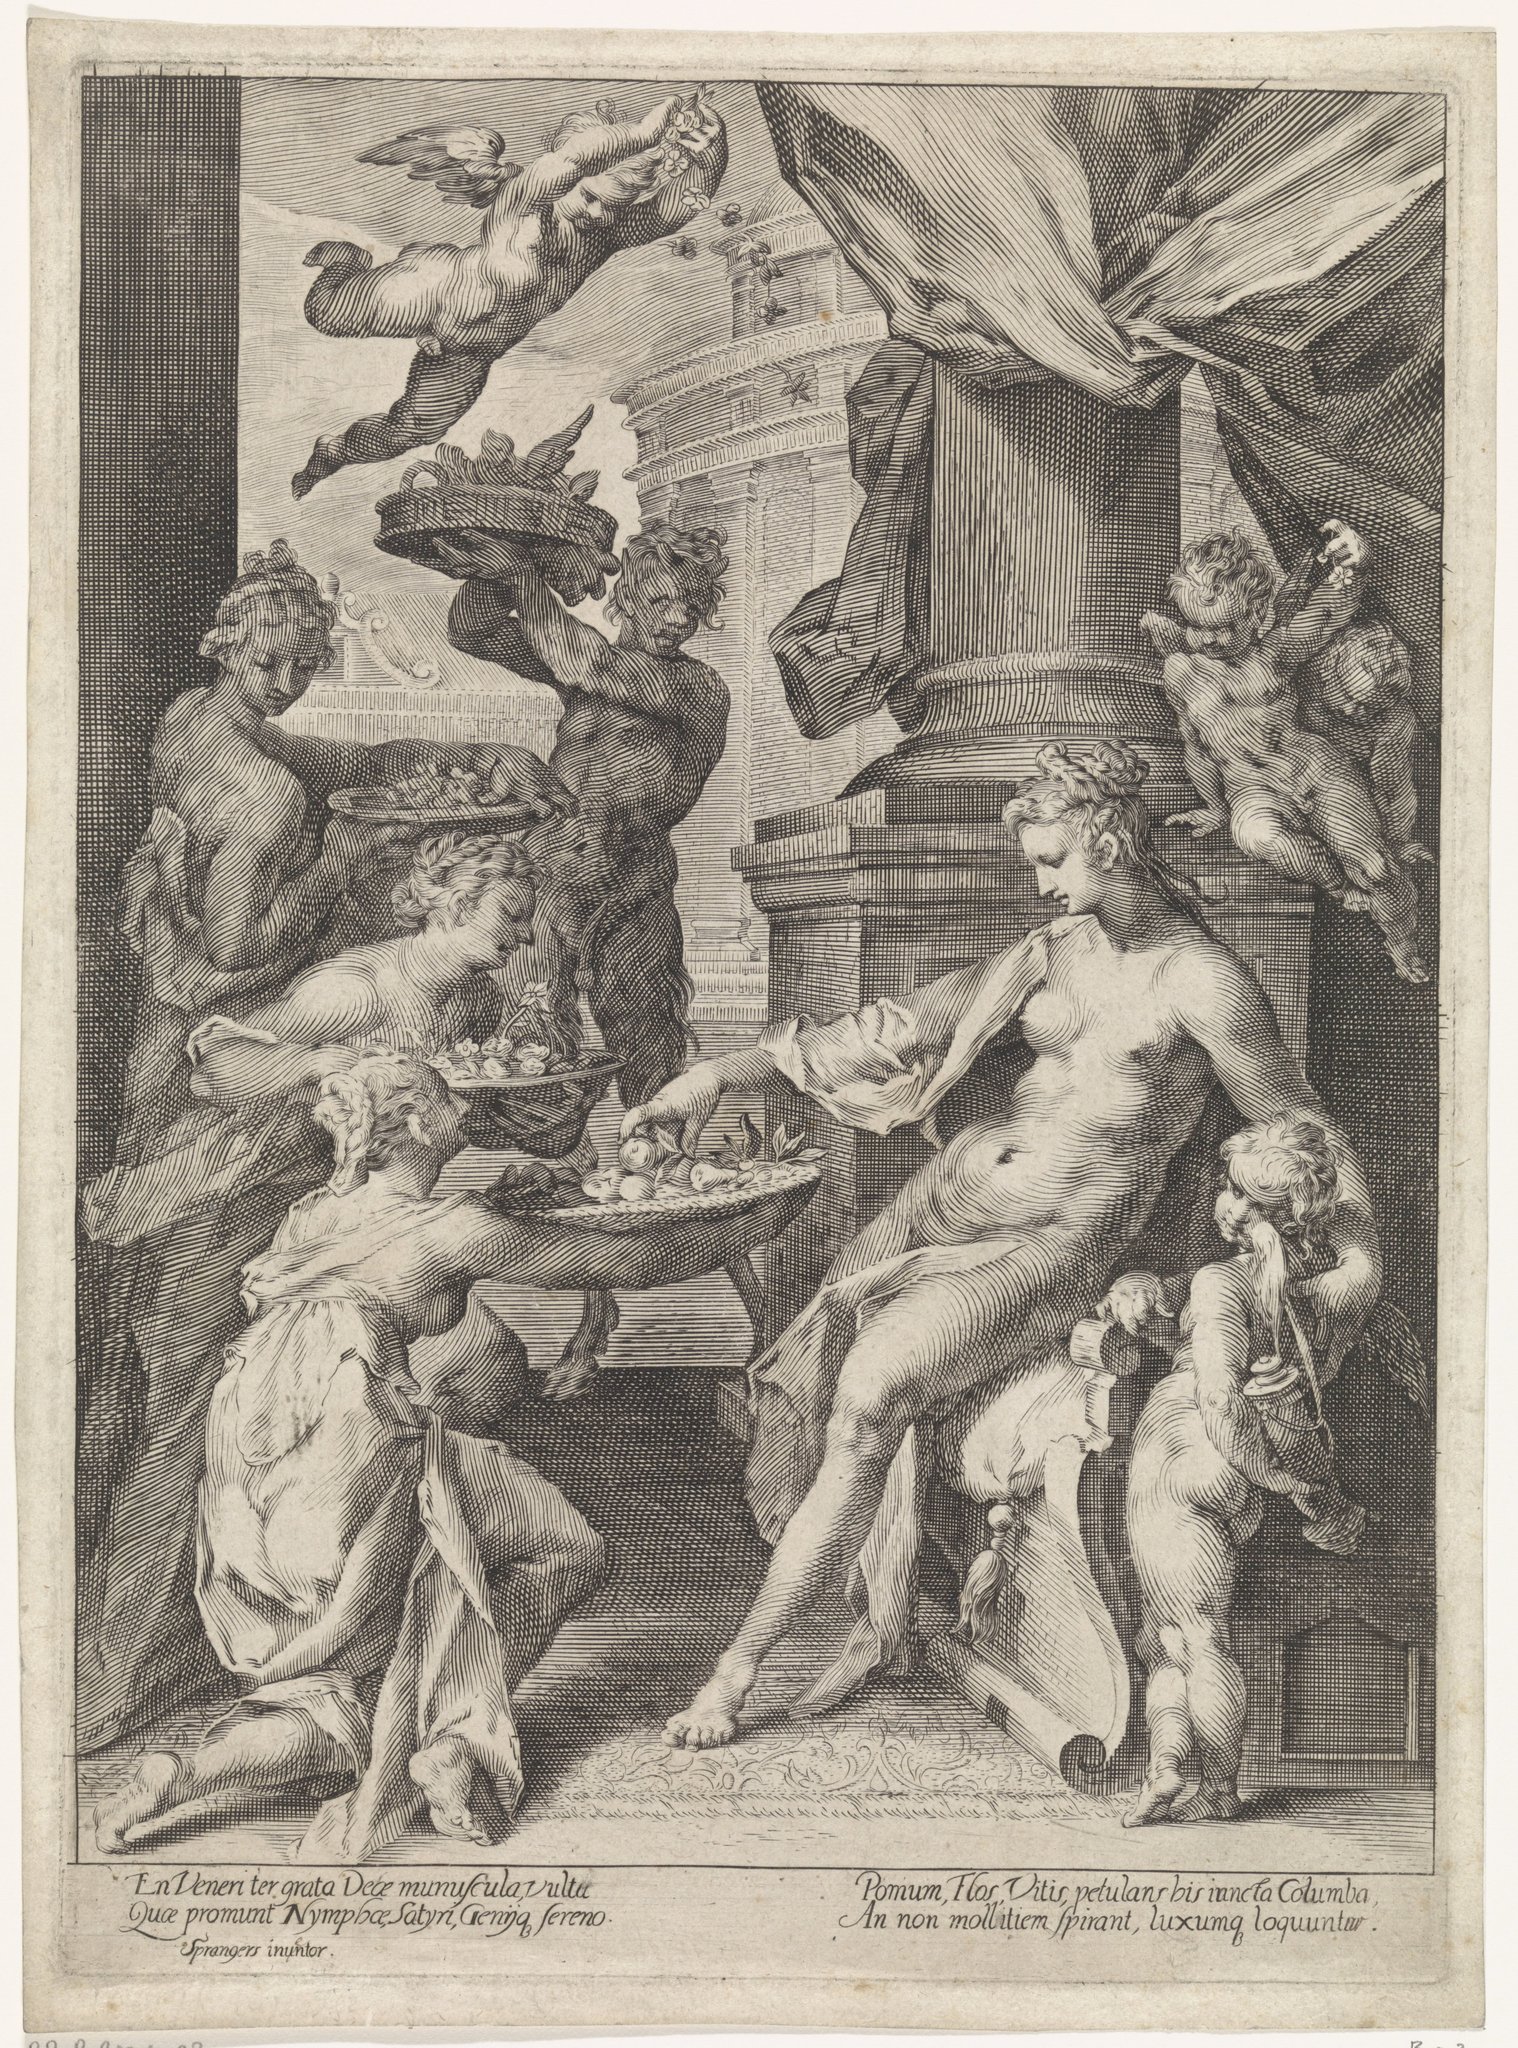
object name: print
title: Venus Honored by Nymphs and a Faun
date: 1589-1678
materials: paper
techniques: engraving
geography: netherlands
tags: nymphs (in general); 'ninfe in commune' (ripa), veneration of venus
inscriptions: collector's mark: Lugt 2228, collector's mark: Lugt 2760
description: Venus, met Amor aan haar zijde, ontvangt manden met bloemen en vruchten van de nimfen. Een sater brengt een mand met gevogelte.